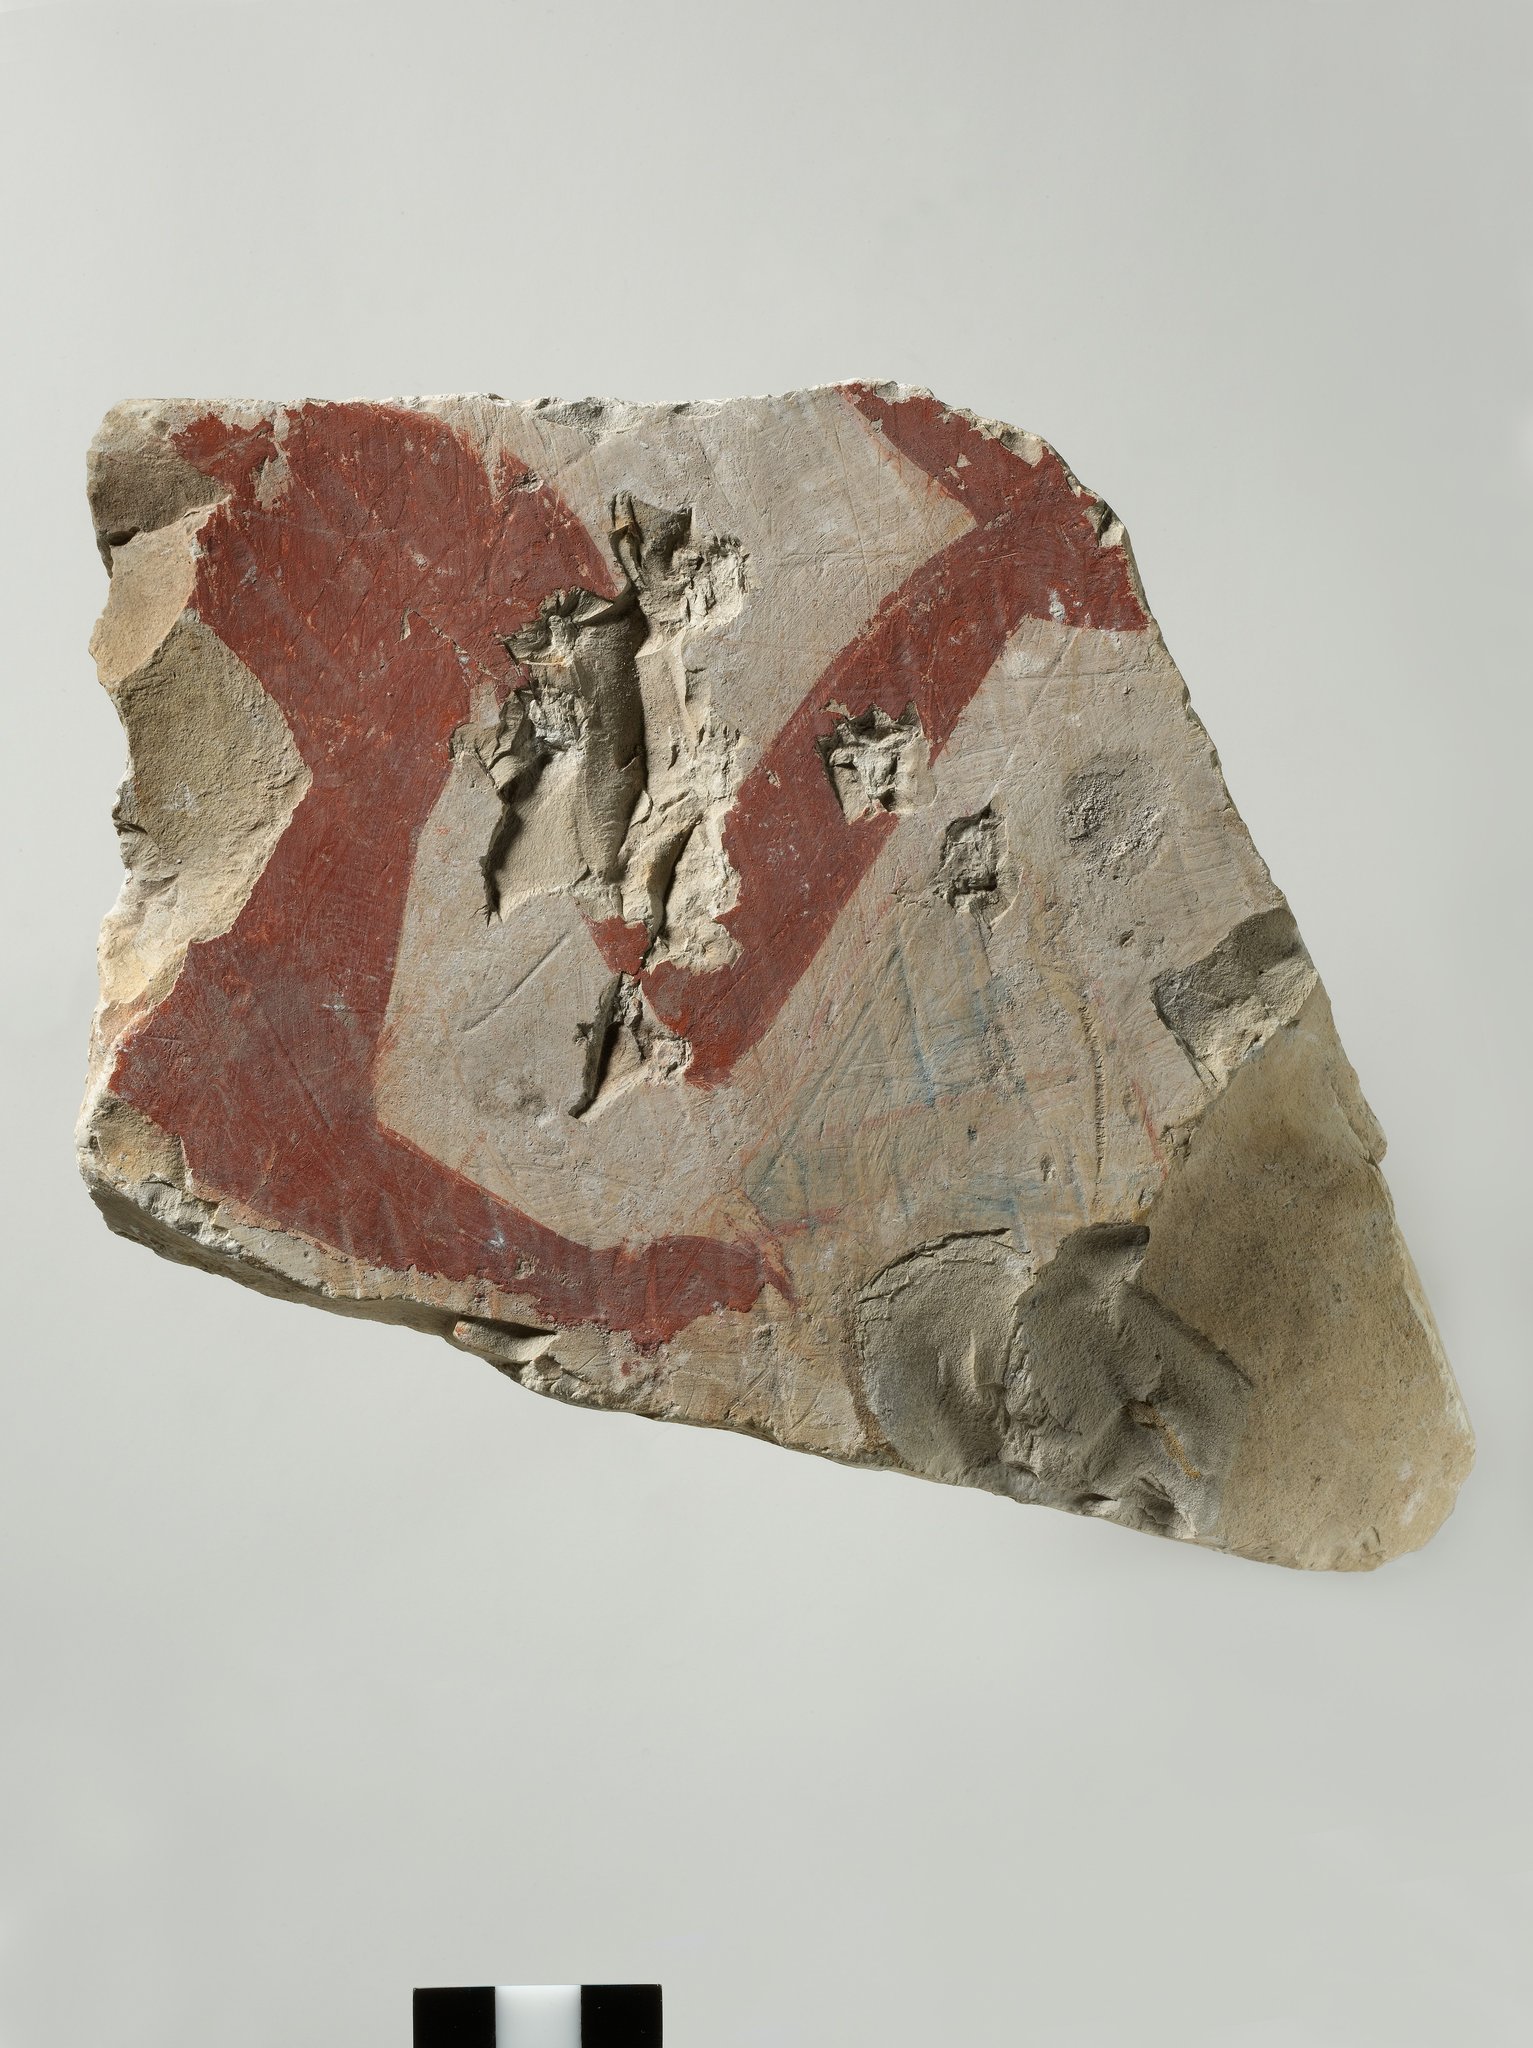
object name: relief fragment, tomb of meketre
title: Relief fragment from the tomb of Meketre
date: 1981-1975 BCE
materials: limestone, paint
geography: egypt